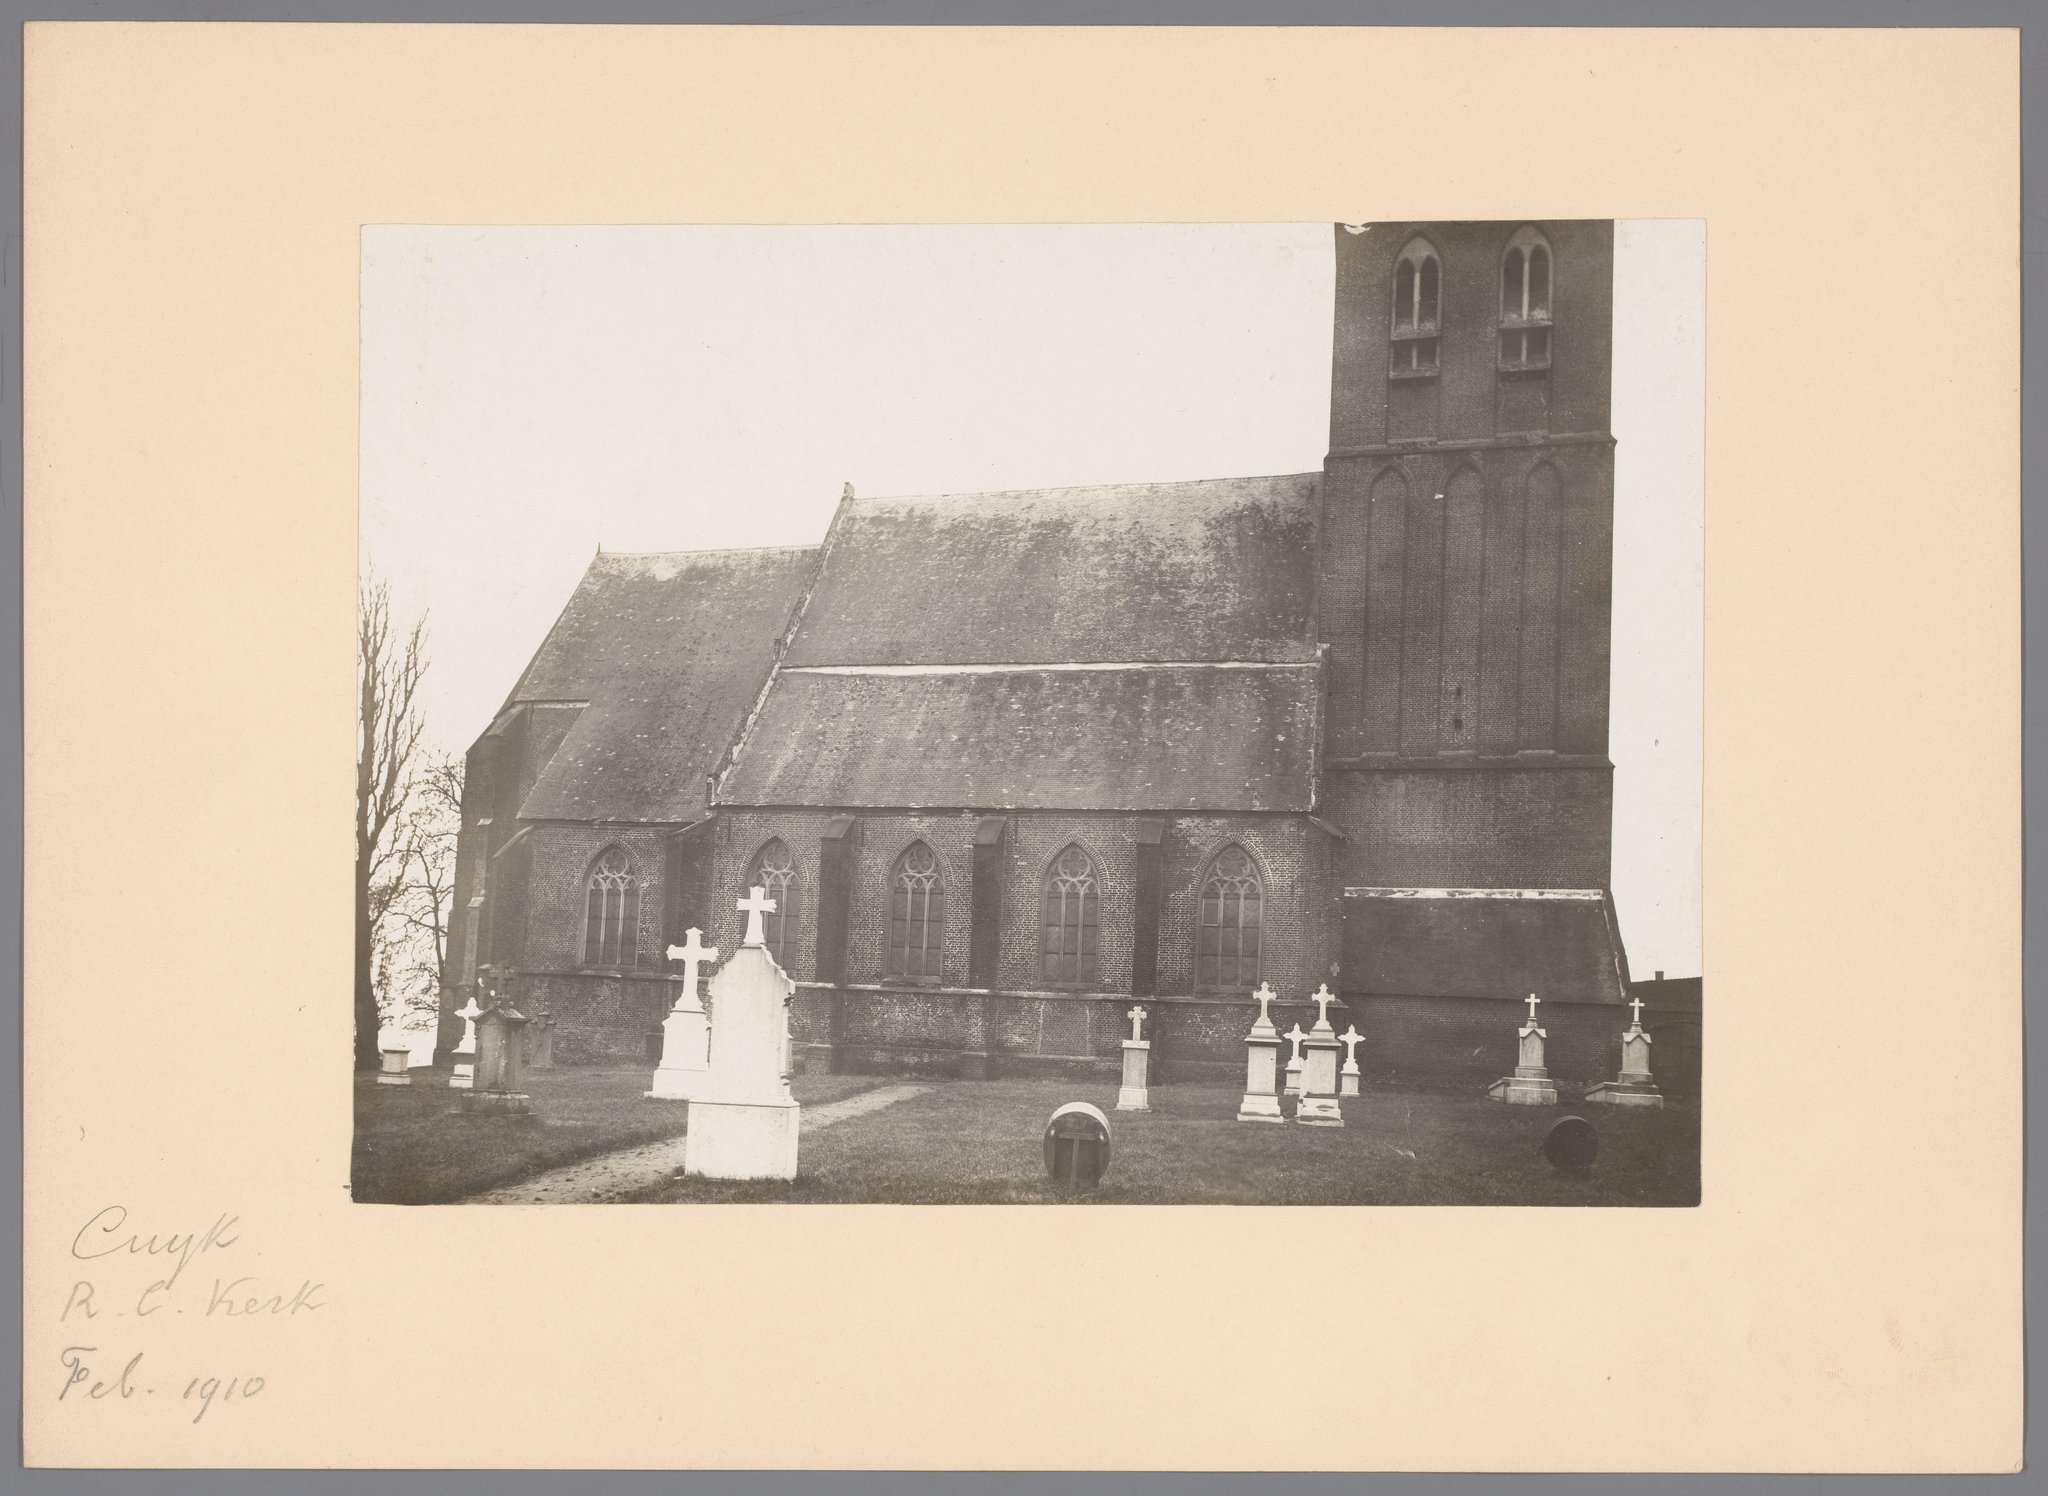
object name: photograph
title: Gezicht op de oude Sint-Martinuskerk te Cuijk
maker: anoniem (monumentenzorg)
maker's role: fotograaf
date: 1910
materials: cardboard, photographic support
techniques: gelatin silver print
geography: cuijk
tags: church (exterior), churchyard, cemetery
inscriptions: annotation: ‘Cuijk/ R-C. Kerk/ Feb: 1910’